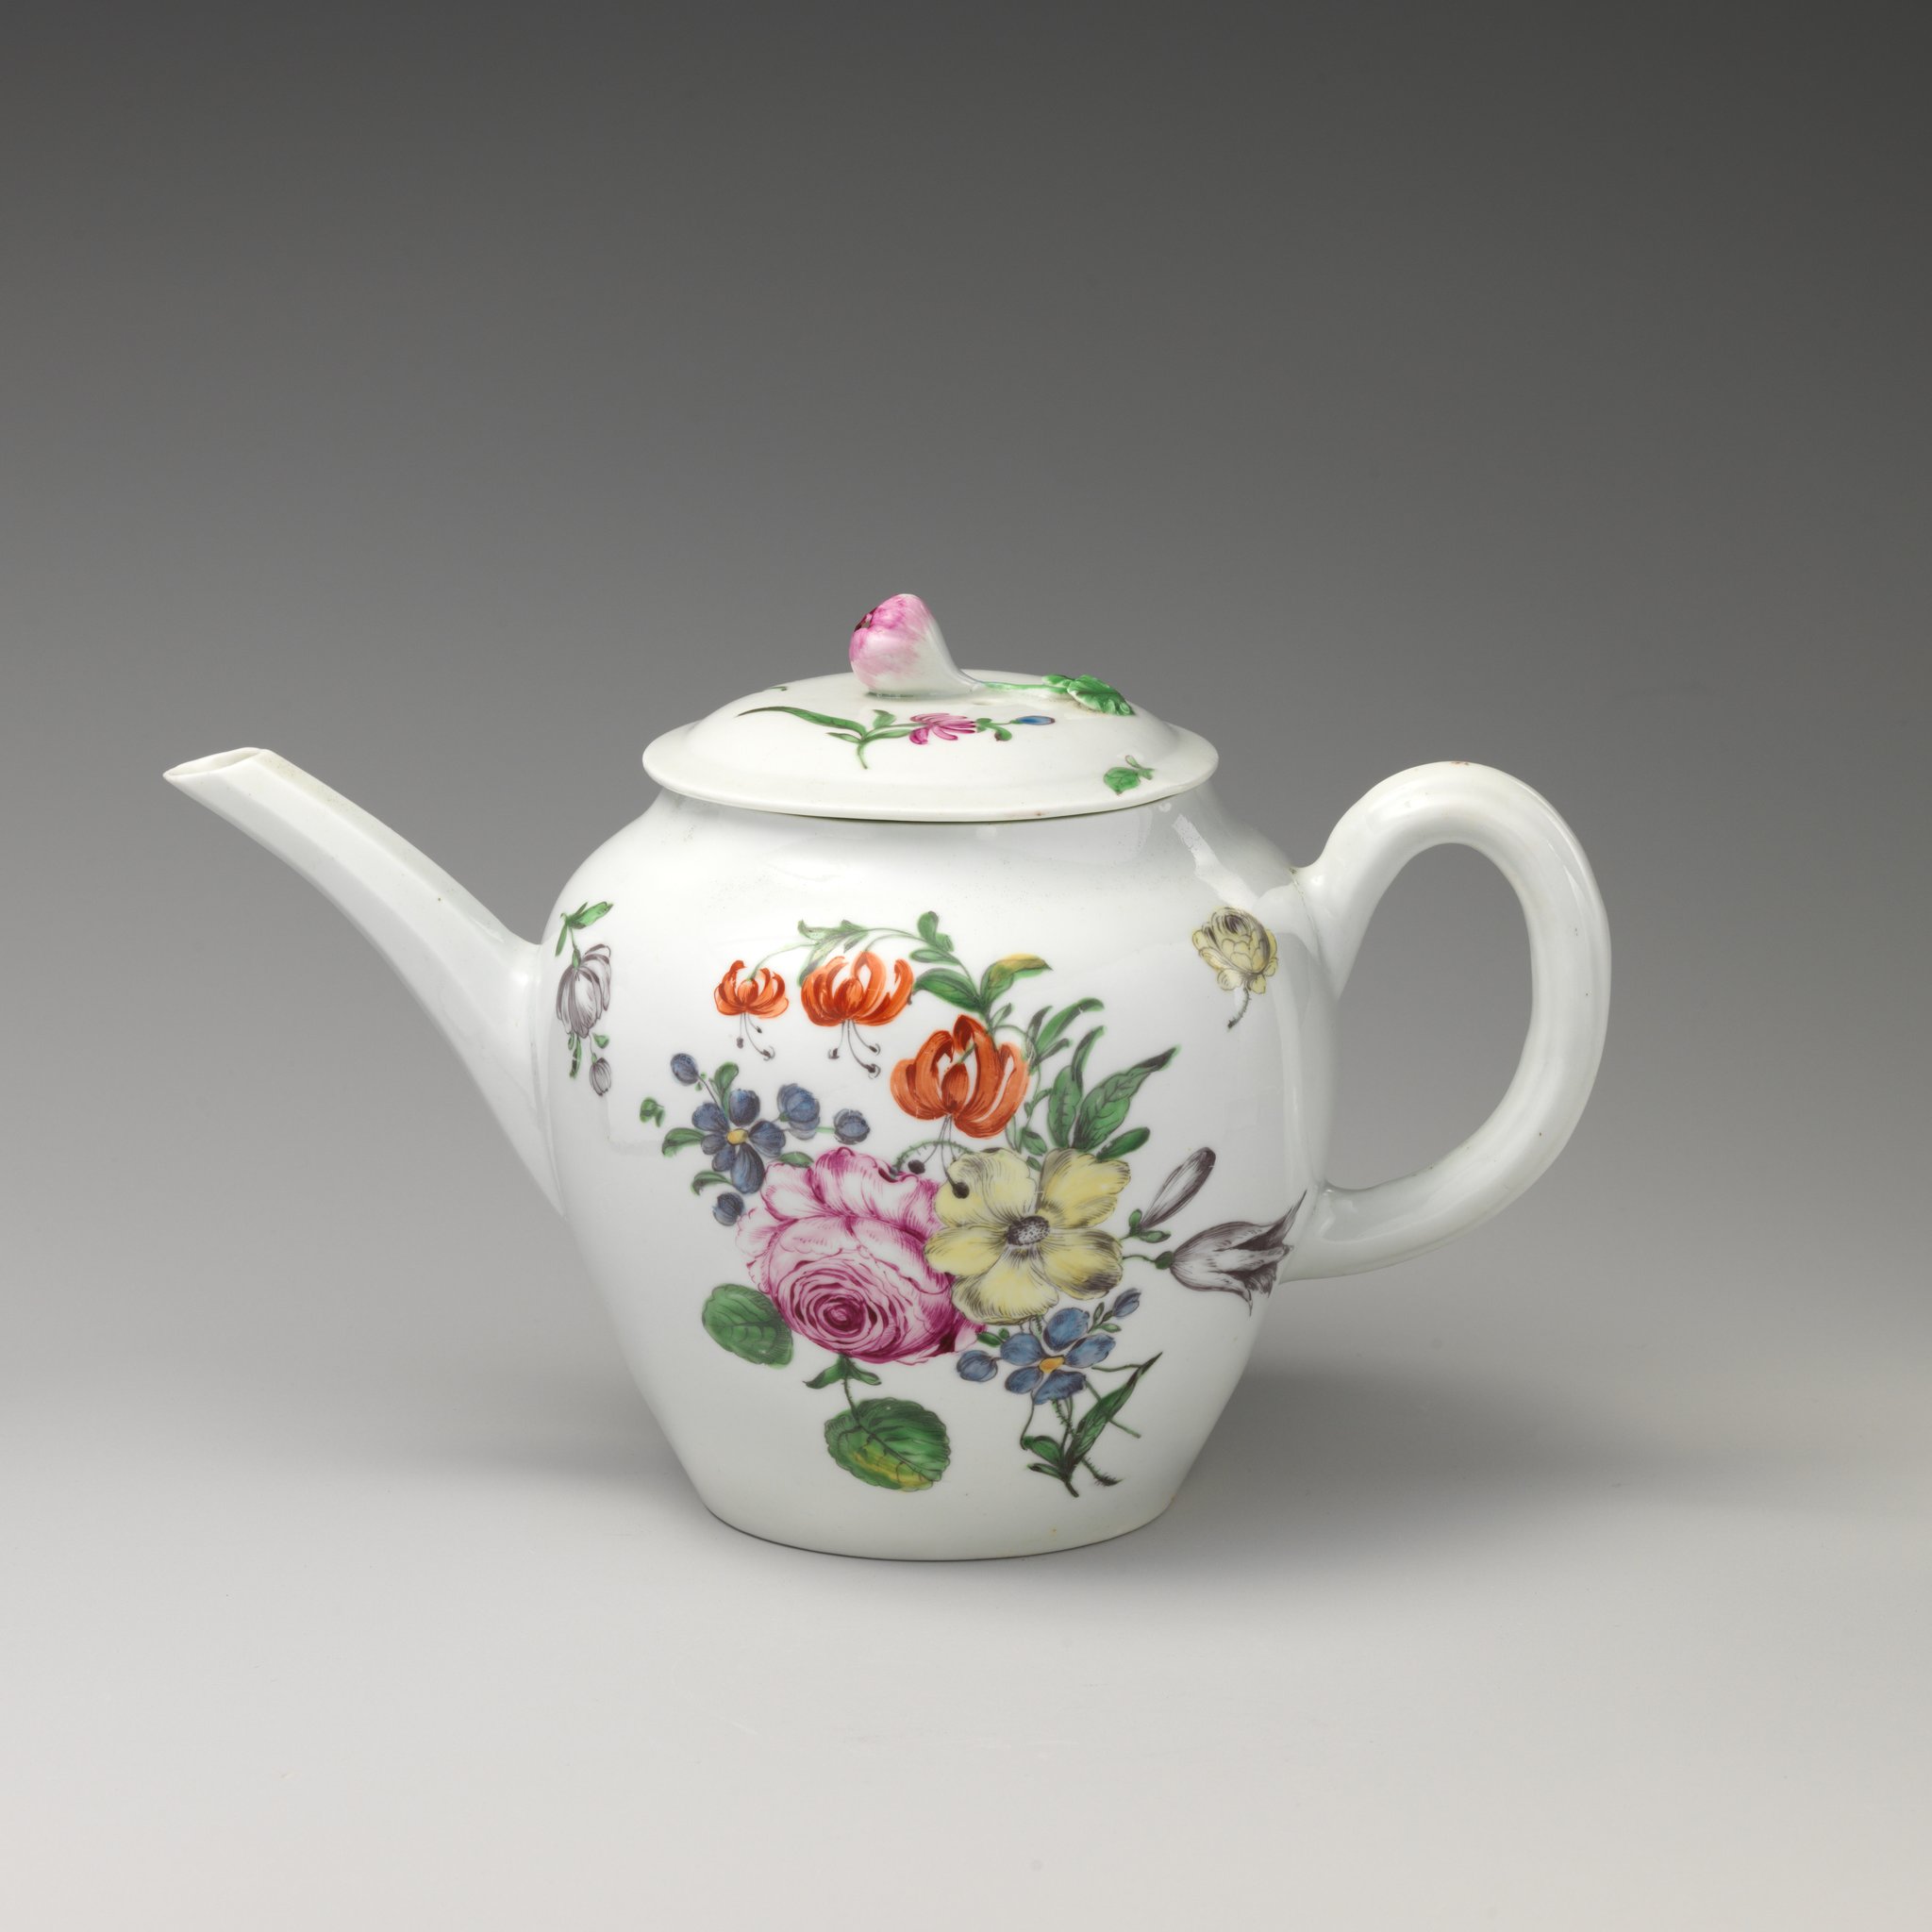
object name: teapot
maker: worcester factory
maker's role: factory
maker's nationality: british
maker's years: 1751-2008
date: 1701-1800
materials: soft paste porcelain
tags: flowers,roses,leaves